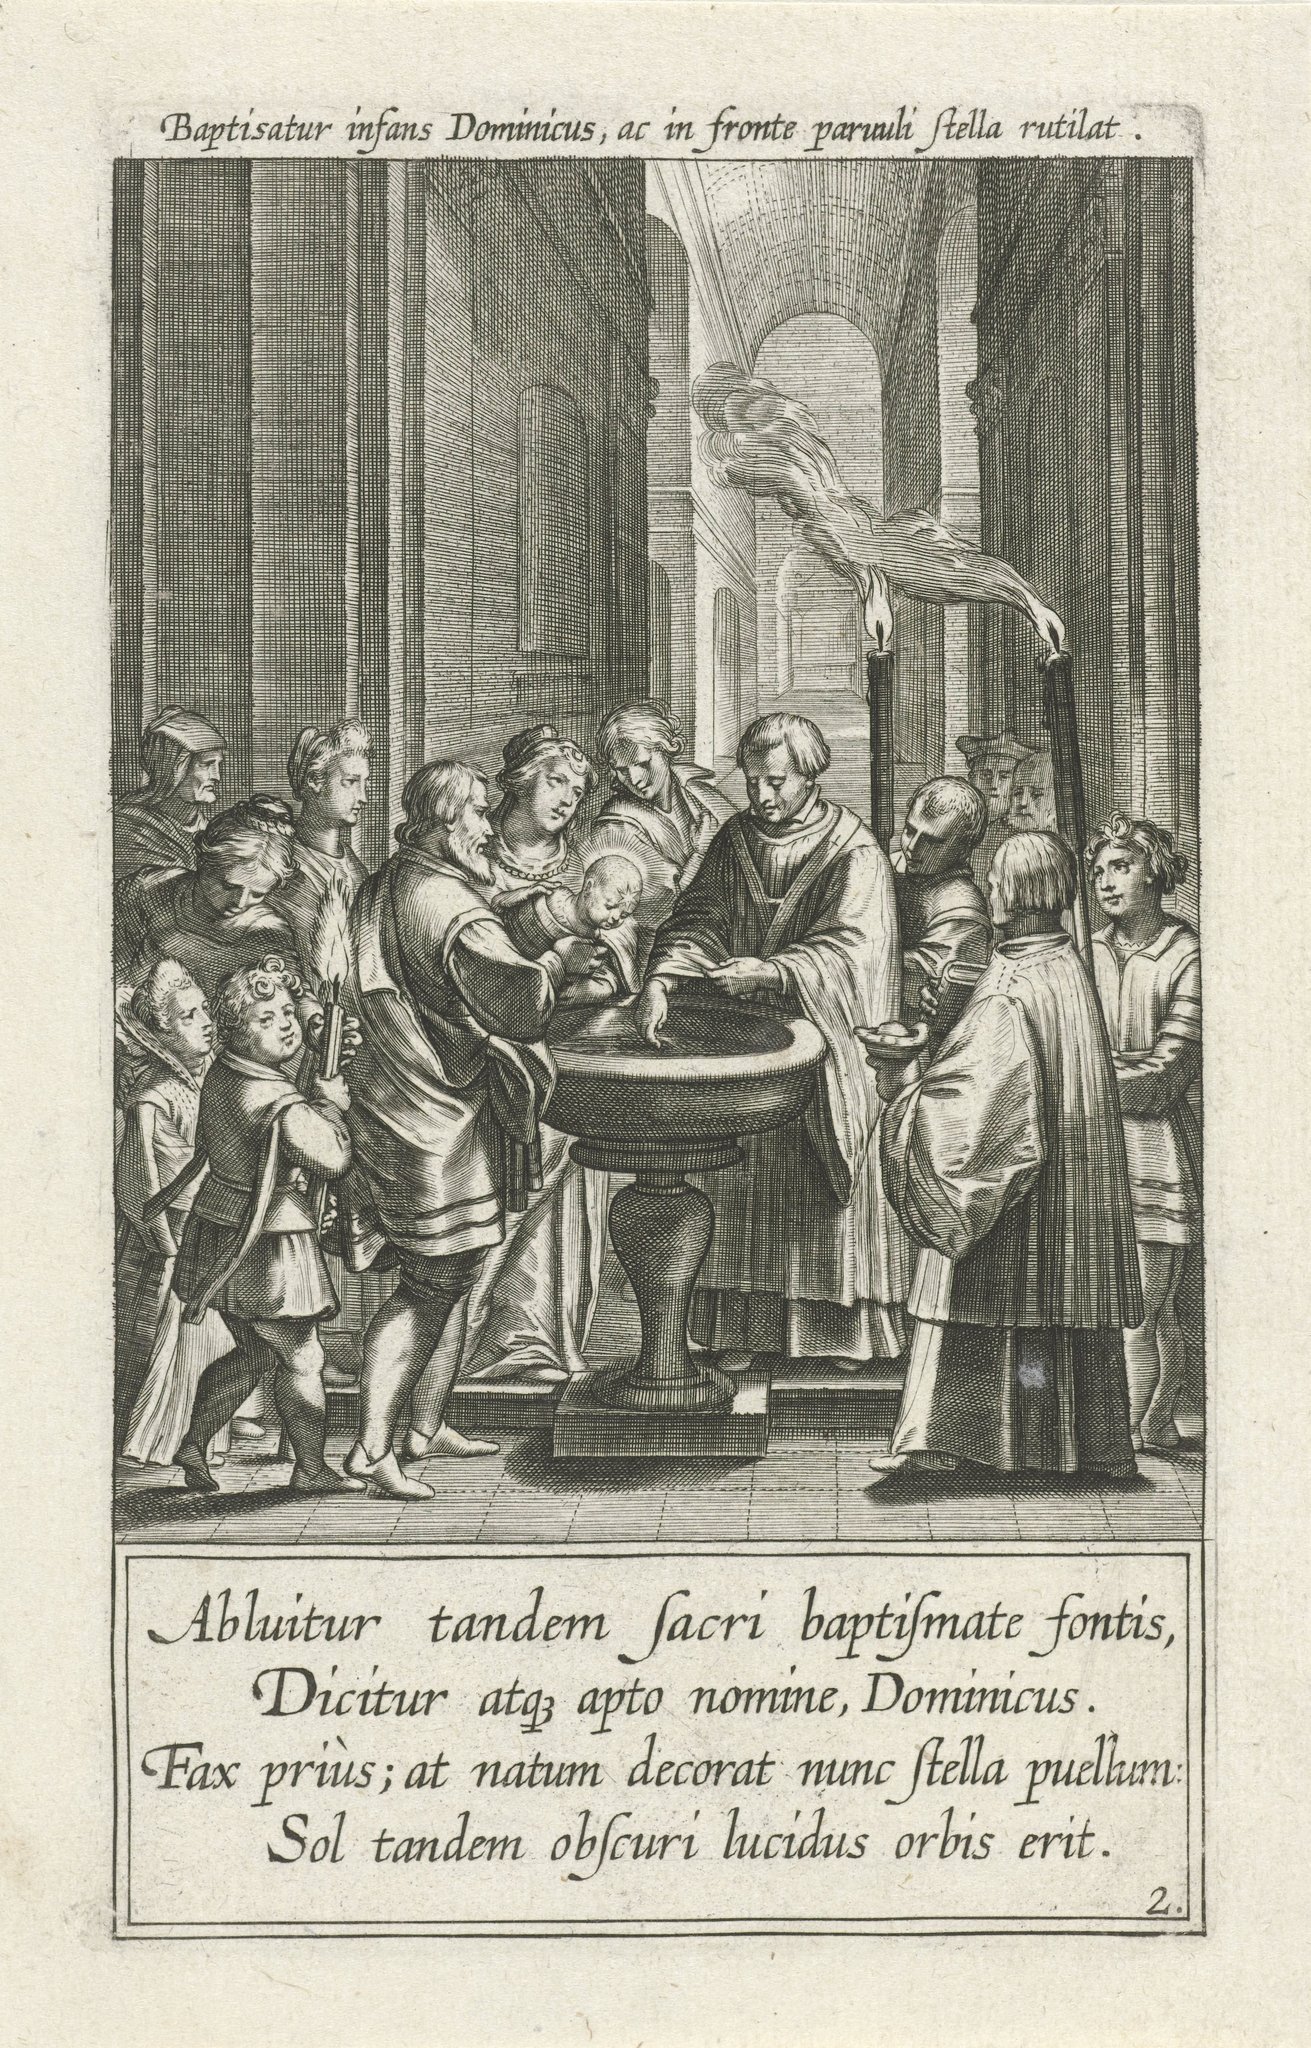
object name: print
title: Leven en mirakels van de heilige Dominicus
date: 1611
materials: paper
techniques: engraving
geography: antwerp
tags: at st. dominic's baptism, his godmother sees a star descend on his brow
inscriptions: collector's mark: Lugt 2228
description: Een priester doopt de heilige Dominicus. Een ster verschijnt op het hoofd van het kind. De prent heeft een Latijns opschrift en onderschrift en maakt deel uit van een prentserie voor een boek over het leven van de heilige Dominicus.